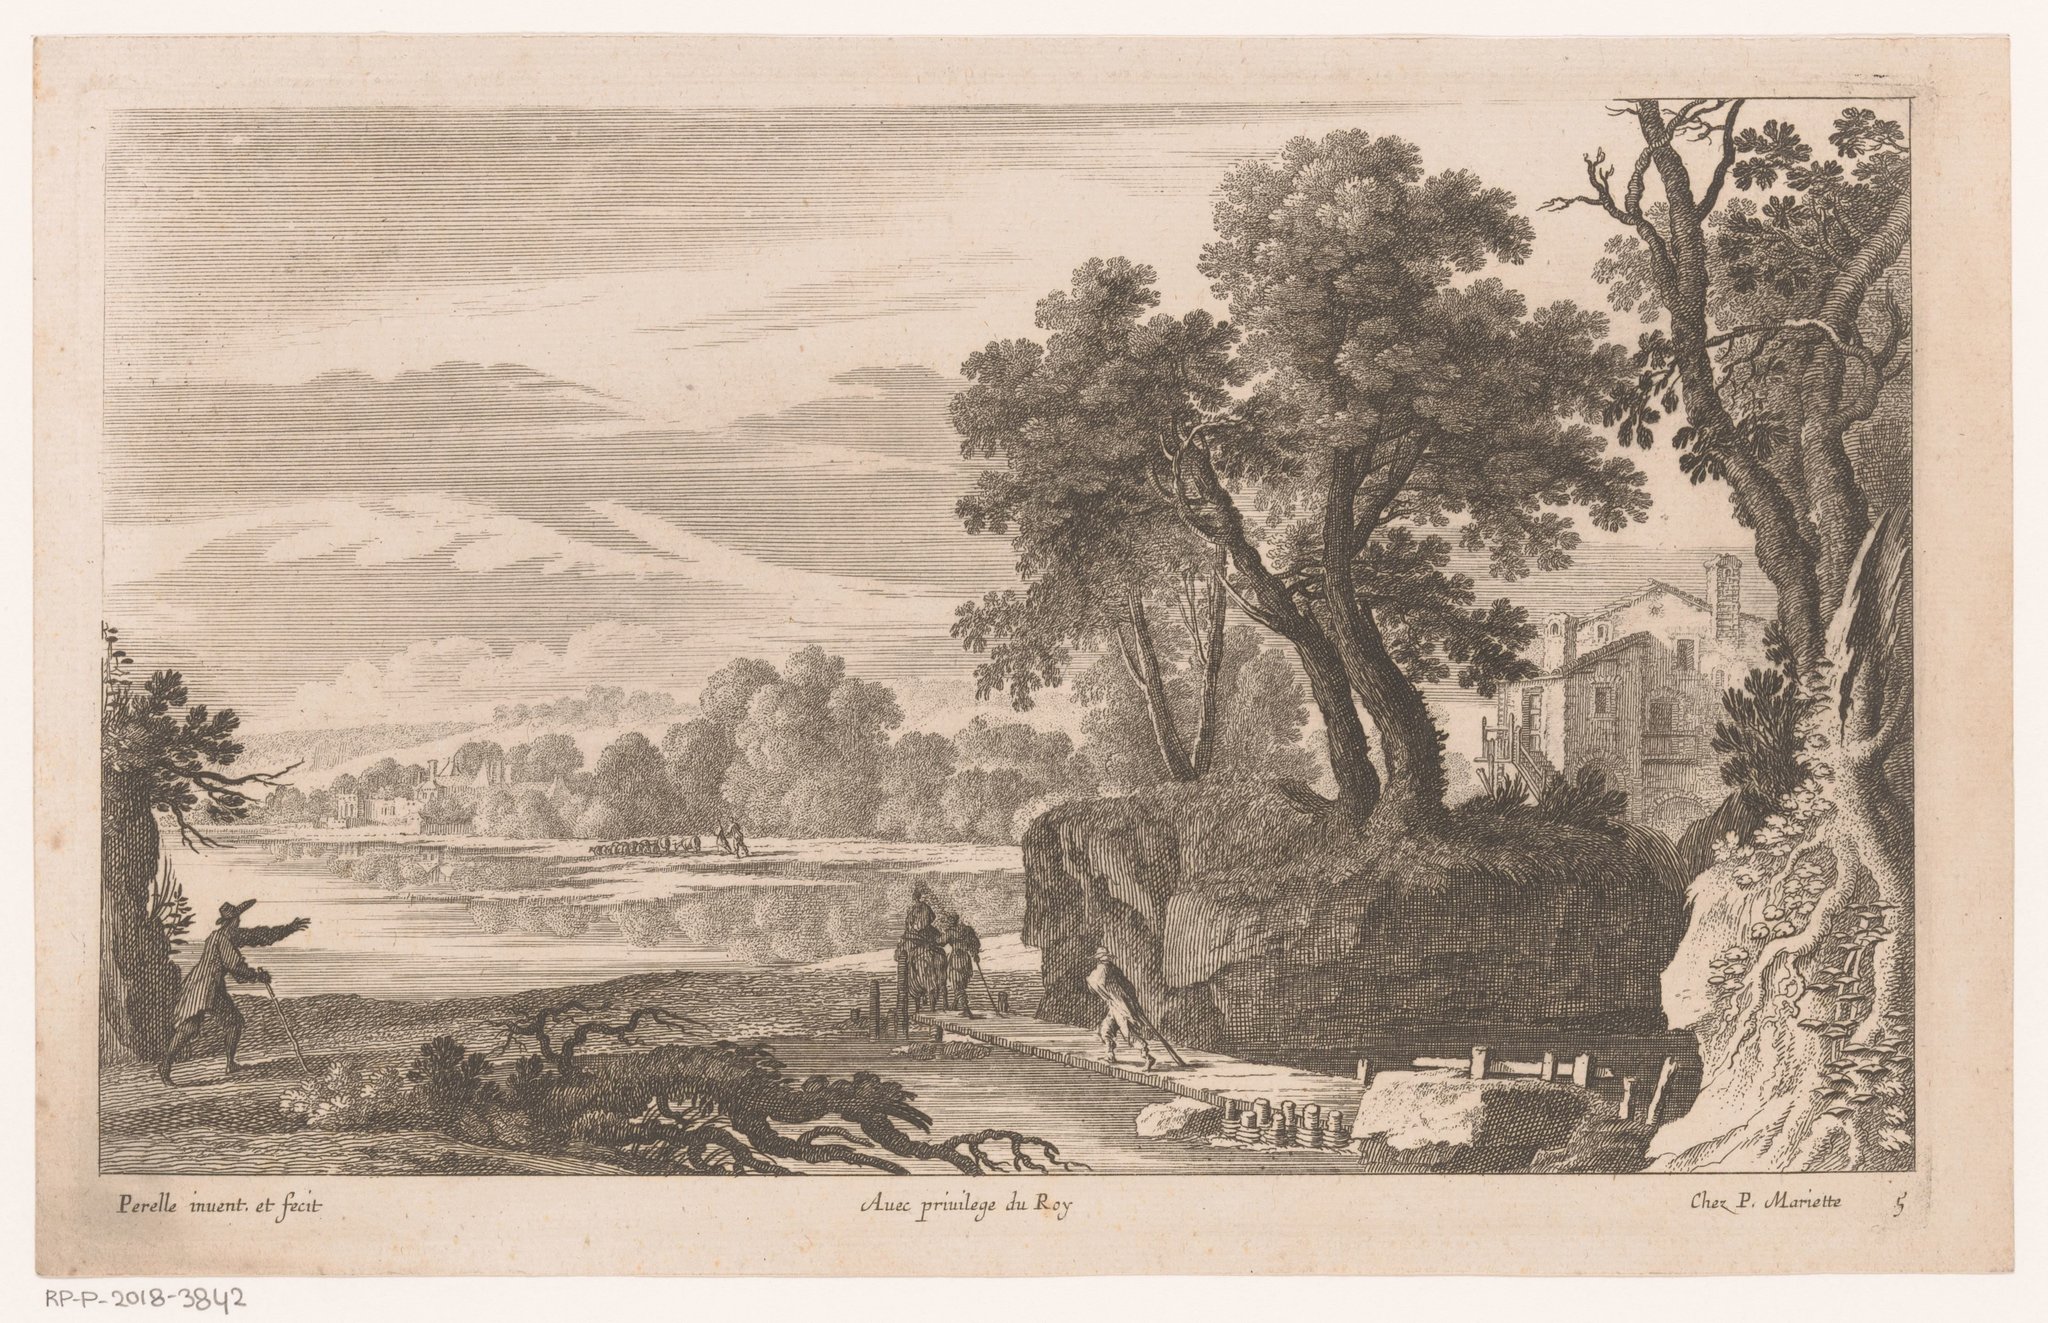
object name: print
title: Rivierlandschap met steiger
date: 1613-1695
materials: paper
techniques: engraving, etching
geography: france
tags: river, pier, quay, wharf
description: Prenten met het signatuur 'Perelle' kunnen zowel door vader Gabriel als door zonen Nicolas en Adam gemaakt zijn.